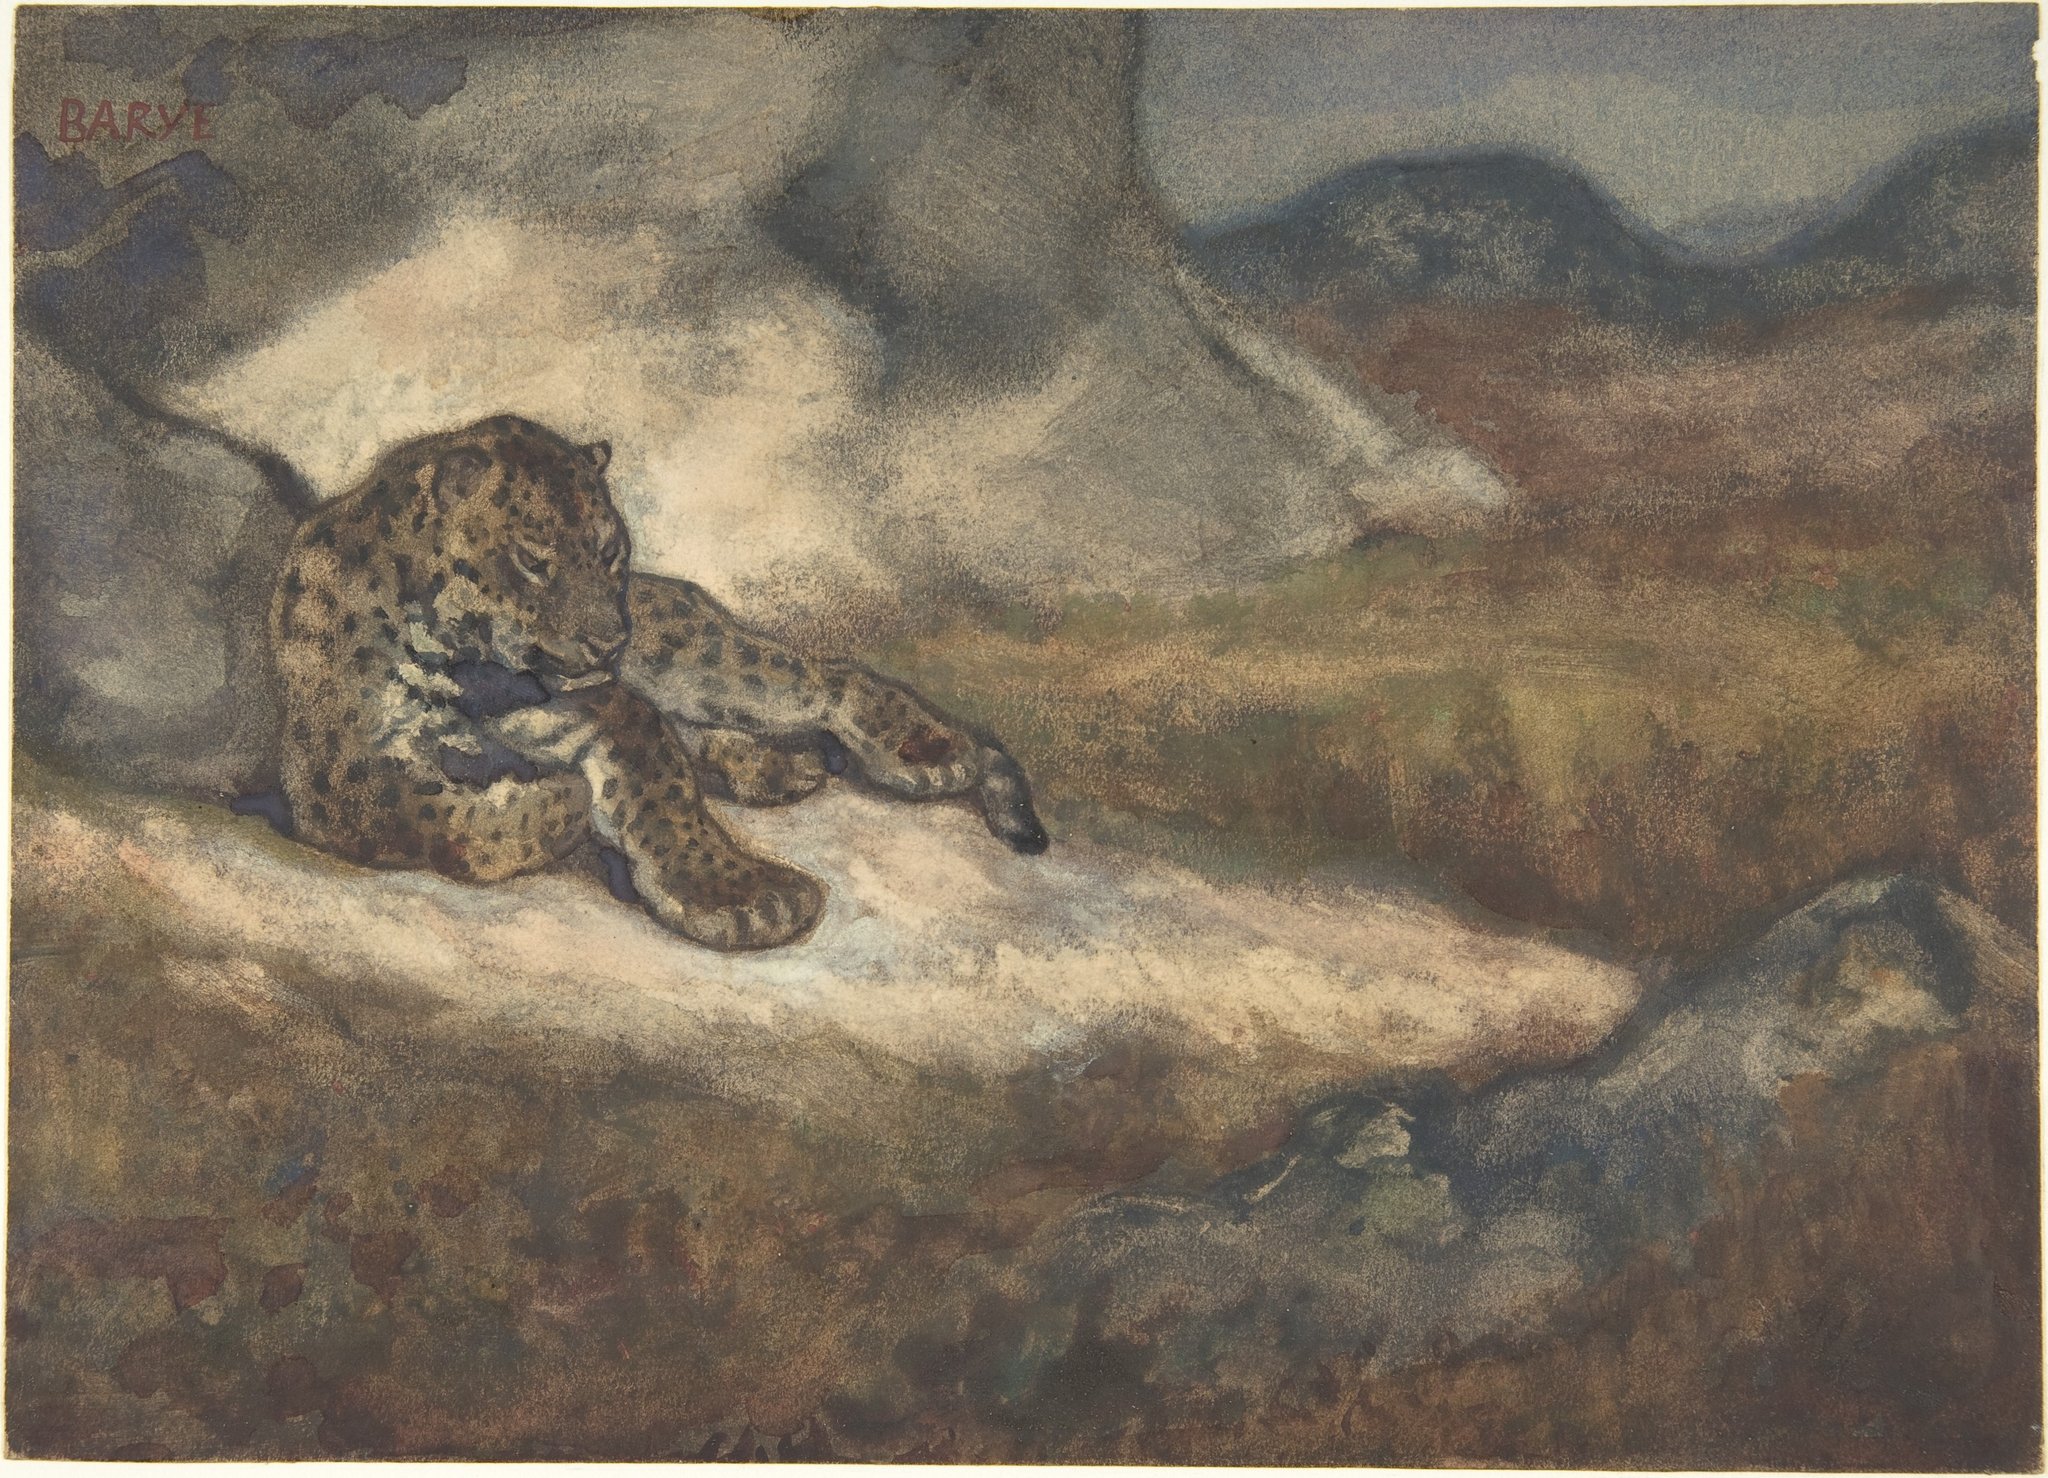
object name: drawing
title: Leopard Lying Down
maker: antoine-louis barye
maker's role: artist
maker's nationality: french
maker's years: 1795-1875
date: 1810-1875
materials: watercolor, paper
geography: france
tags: leopards